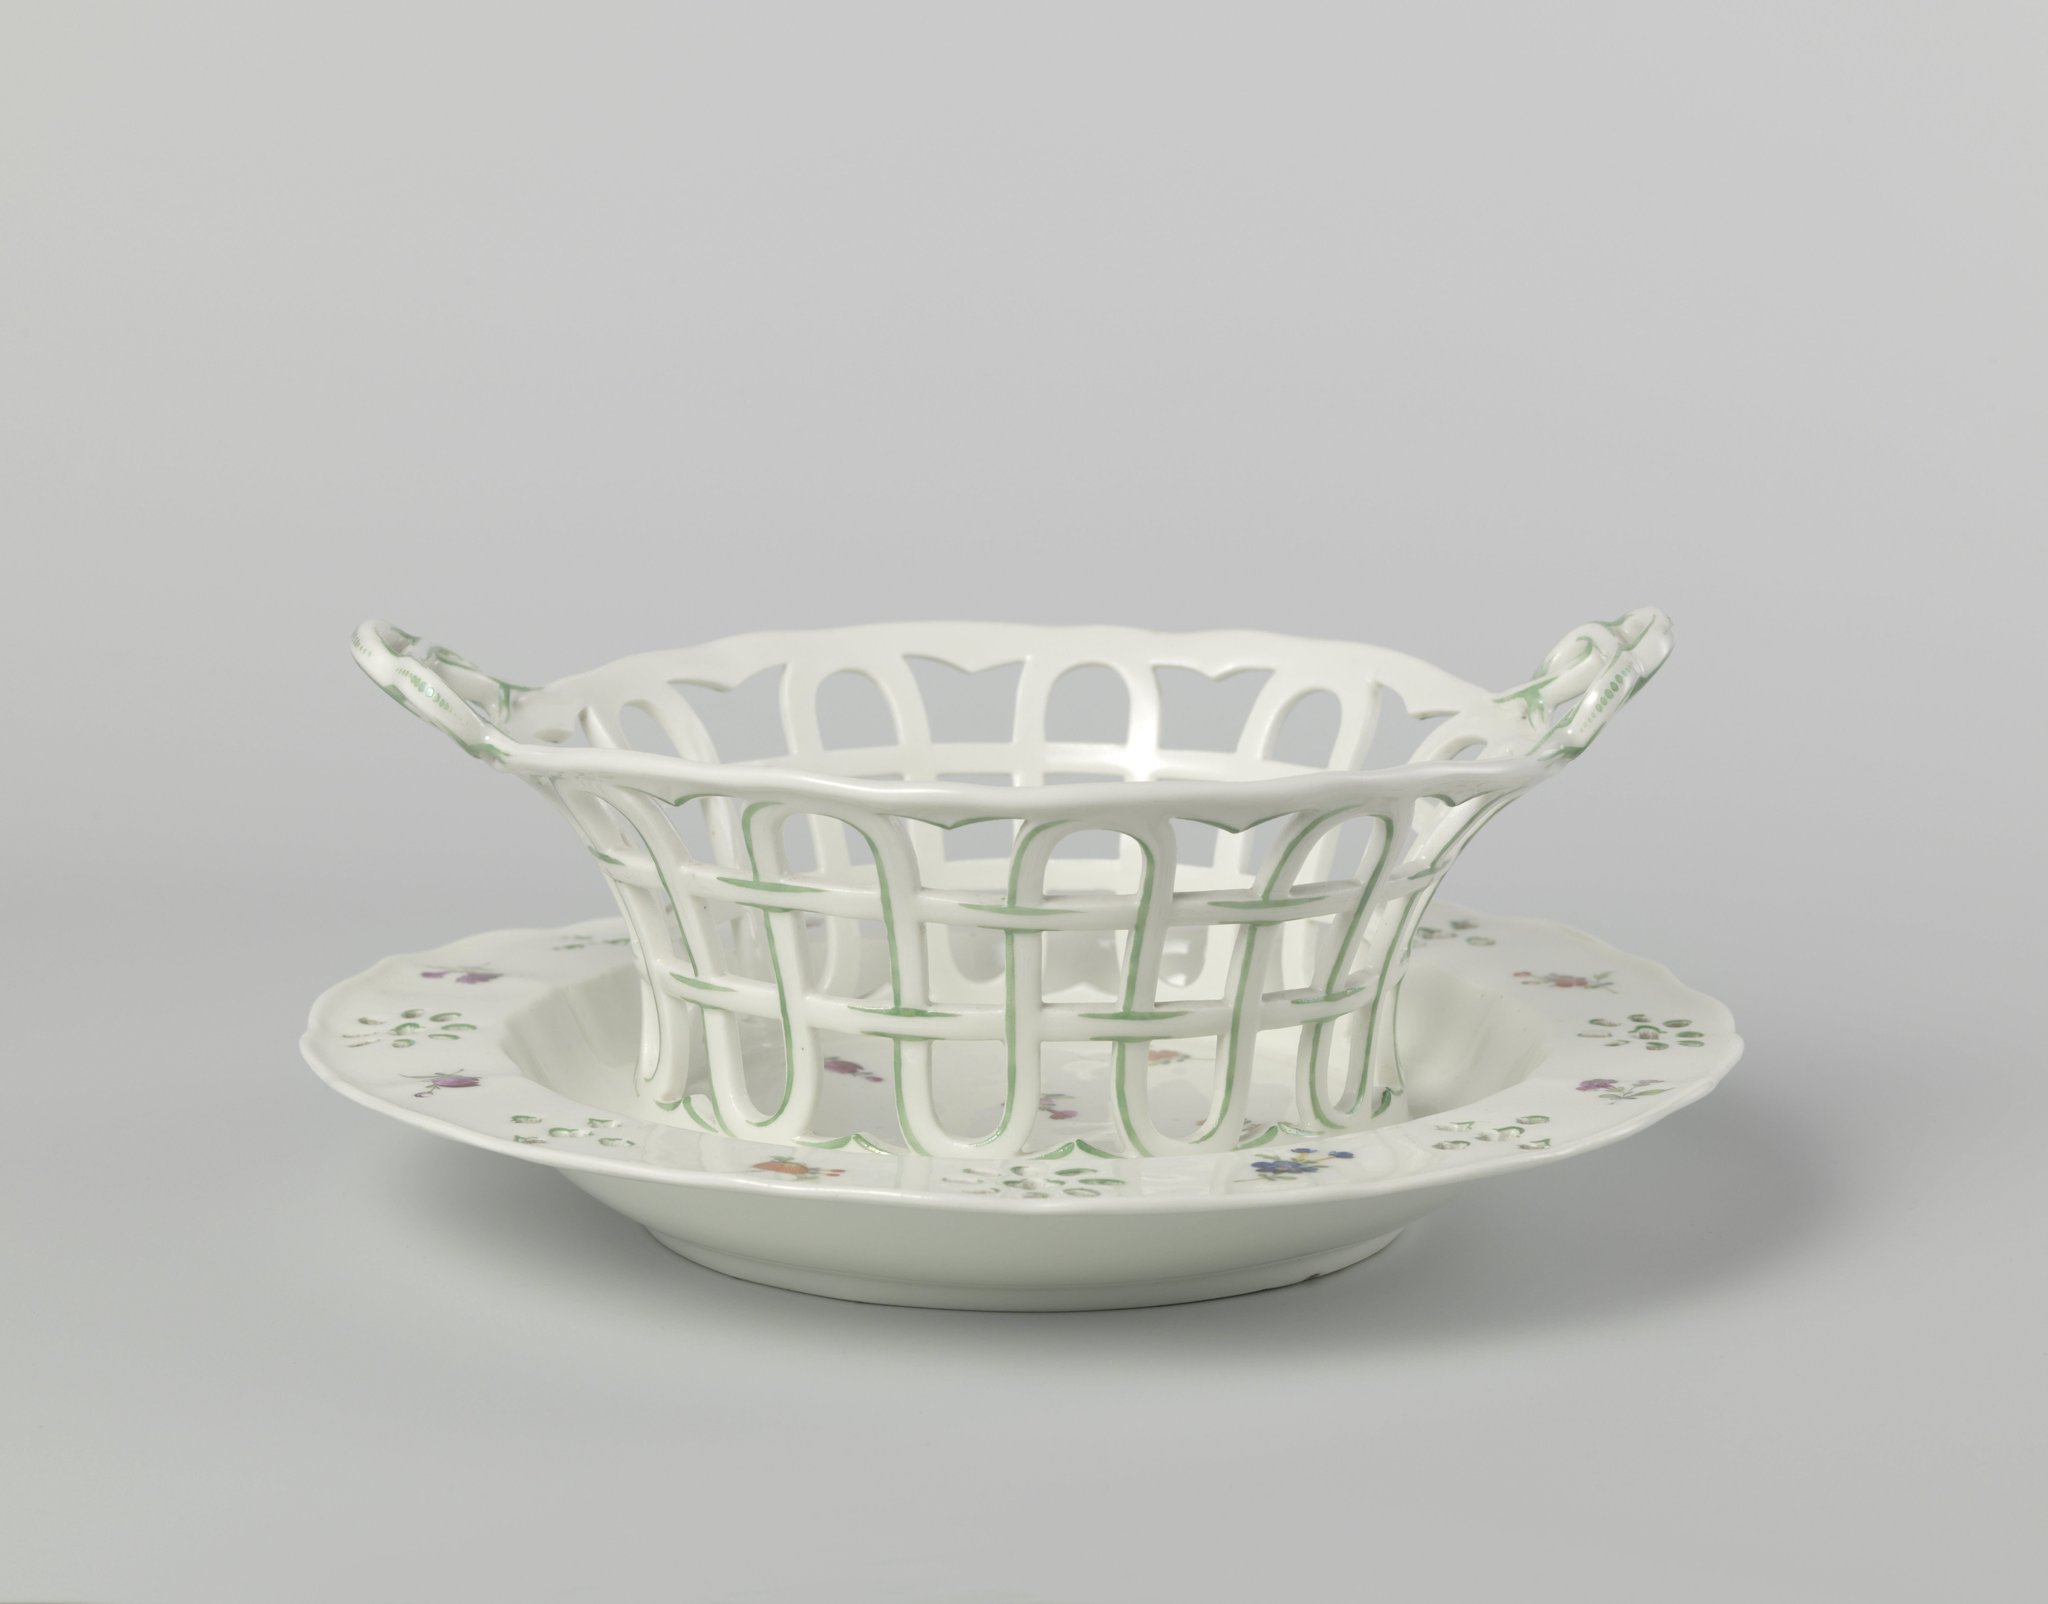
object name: basket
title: Mand op onderschotel, veelkleurig beschilderd met strooibloemen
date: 1784-1809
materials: porcelain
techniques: painted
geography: ouder-amstel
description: Basket and stand. Porcelain. Ouder-Amstel, c. 1786 - 1805. Factory under the direction of Friedrich Daeuber or of Nicolaas Gerard Dommer.